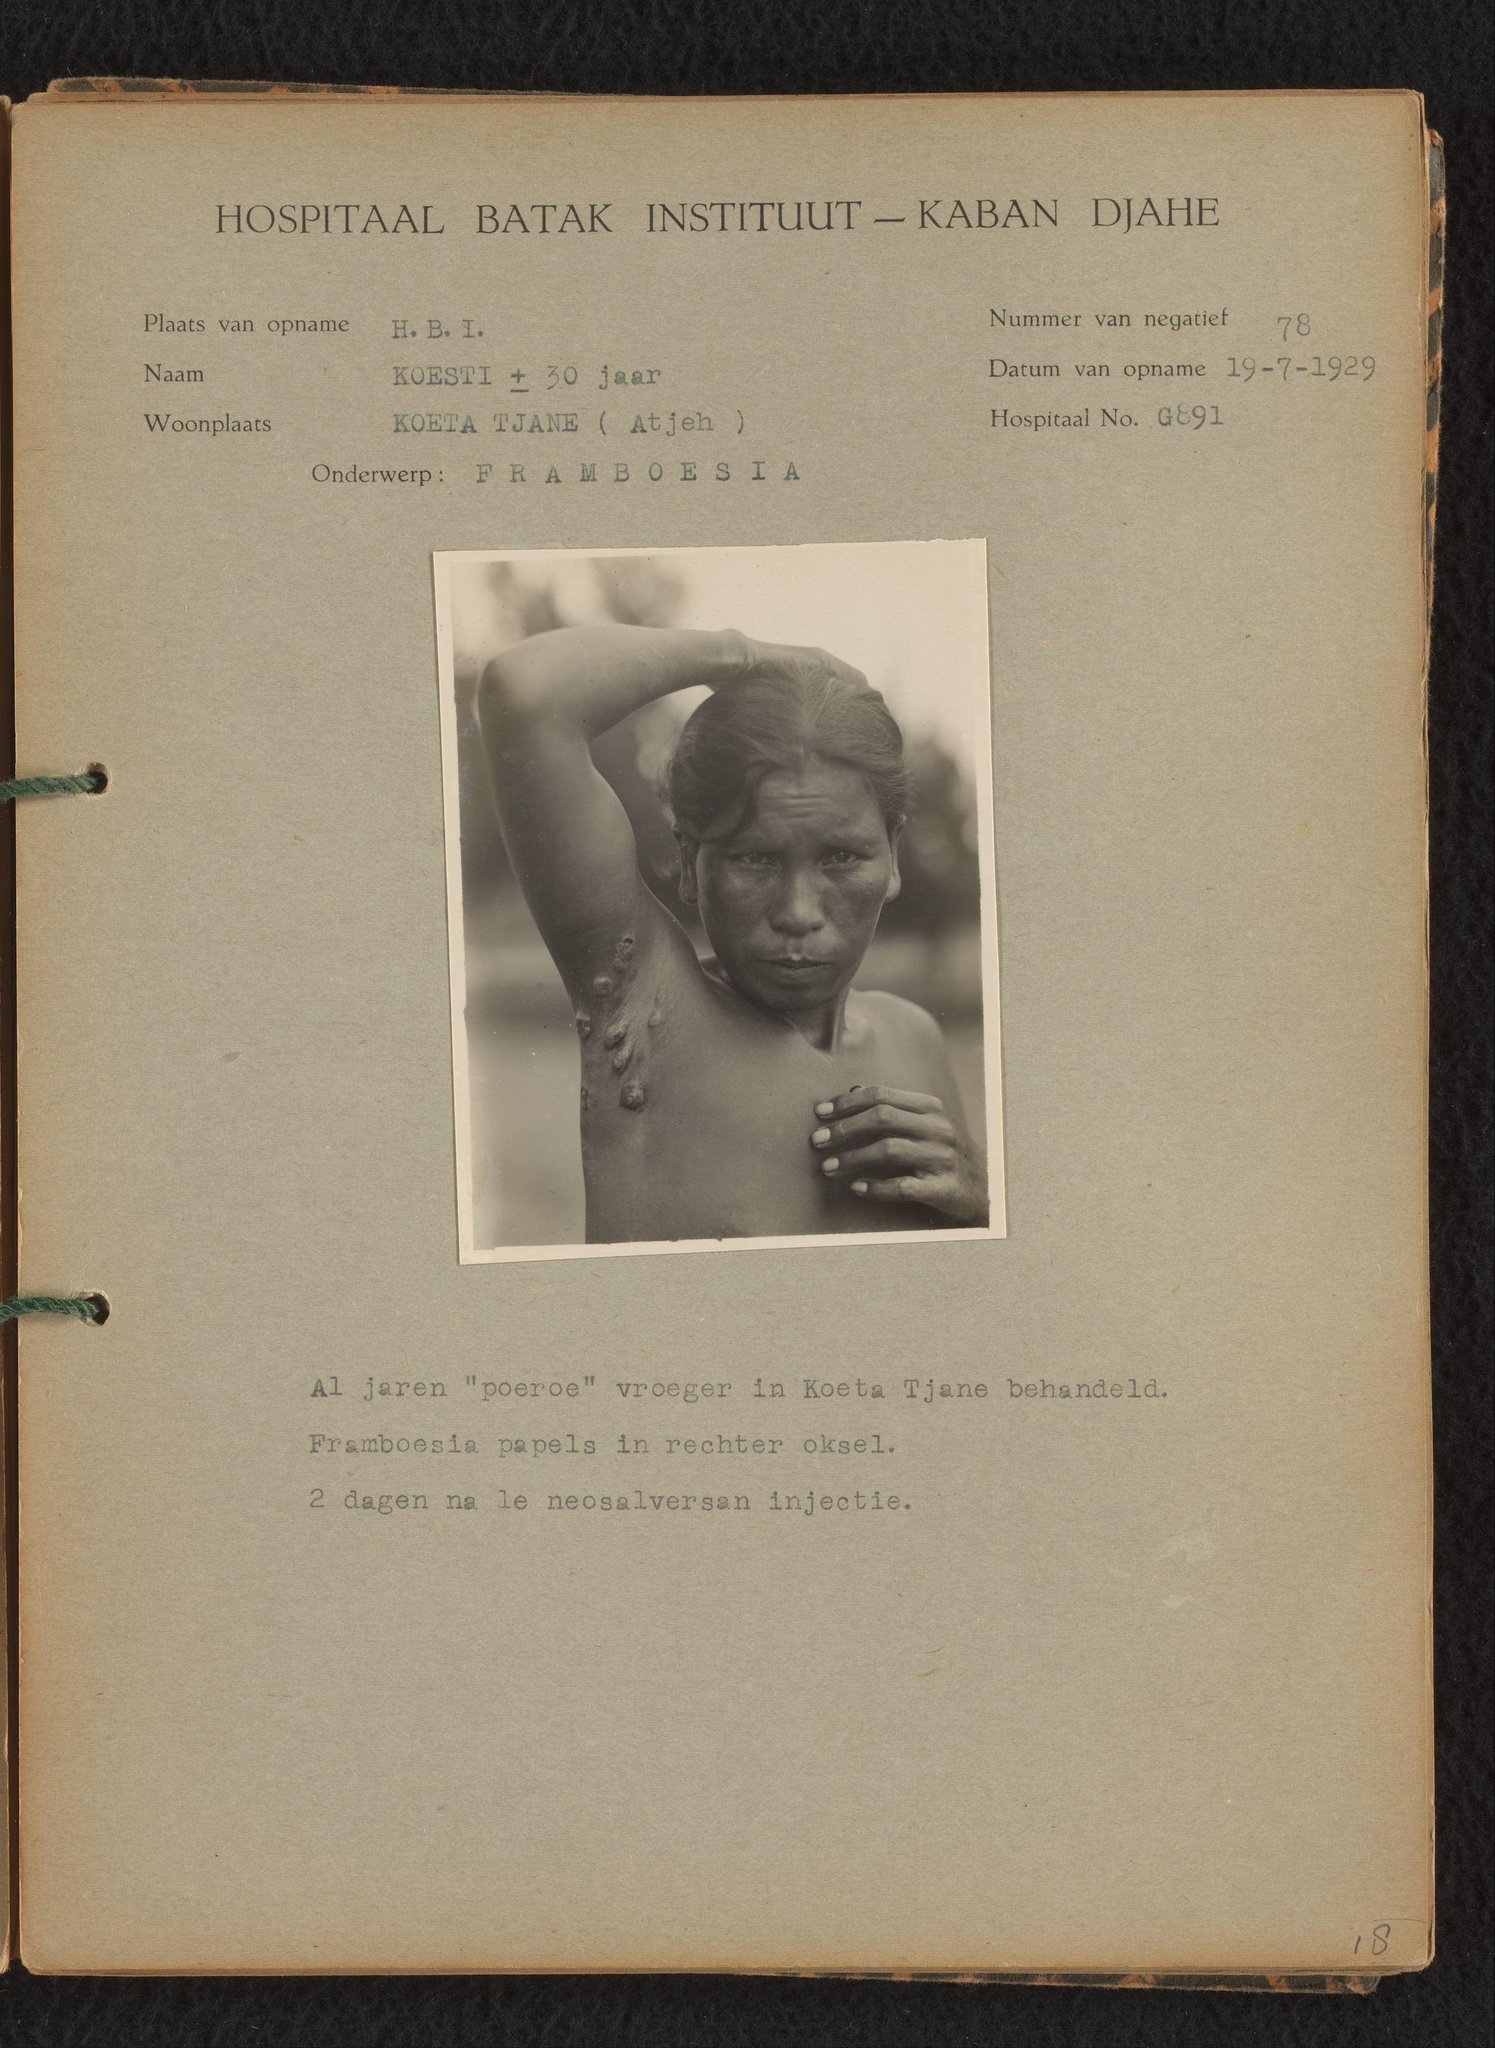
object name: photograph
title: Vrouw met framboesia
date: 1929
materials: cardboard, photographic support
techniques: gelatin silver print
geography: kabanjahe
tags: colonial system, patient, sick person, sumatra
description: Medische foto van een vrouwelijke patiënt genaamd Koesti van ca. 30 jaar met de aandoening framboesia in de oksel. Datum foto: 19 juli 1929. Foto geplakt op voorgedrukt kartonnen blad ingebonden in het fotoalbum over het Hospitaal Batak Instituut te Kabanjaheh op Sumatra in de jaren 1926-1929.